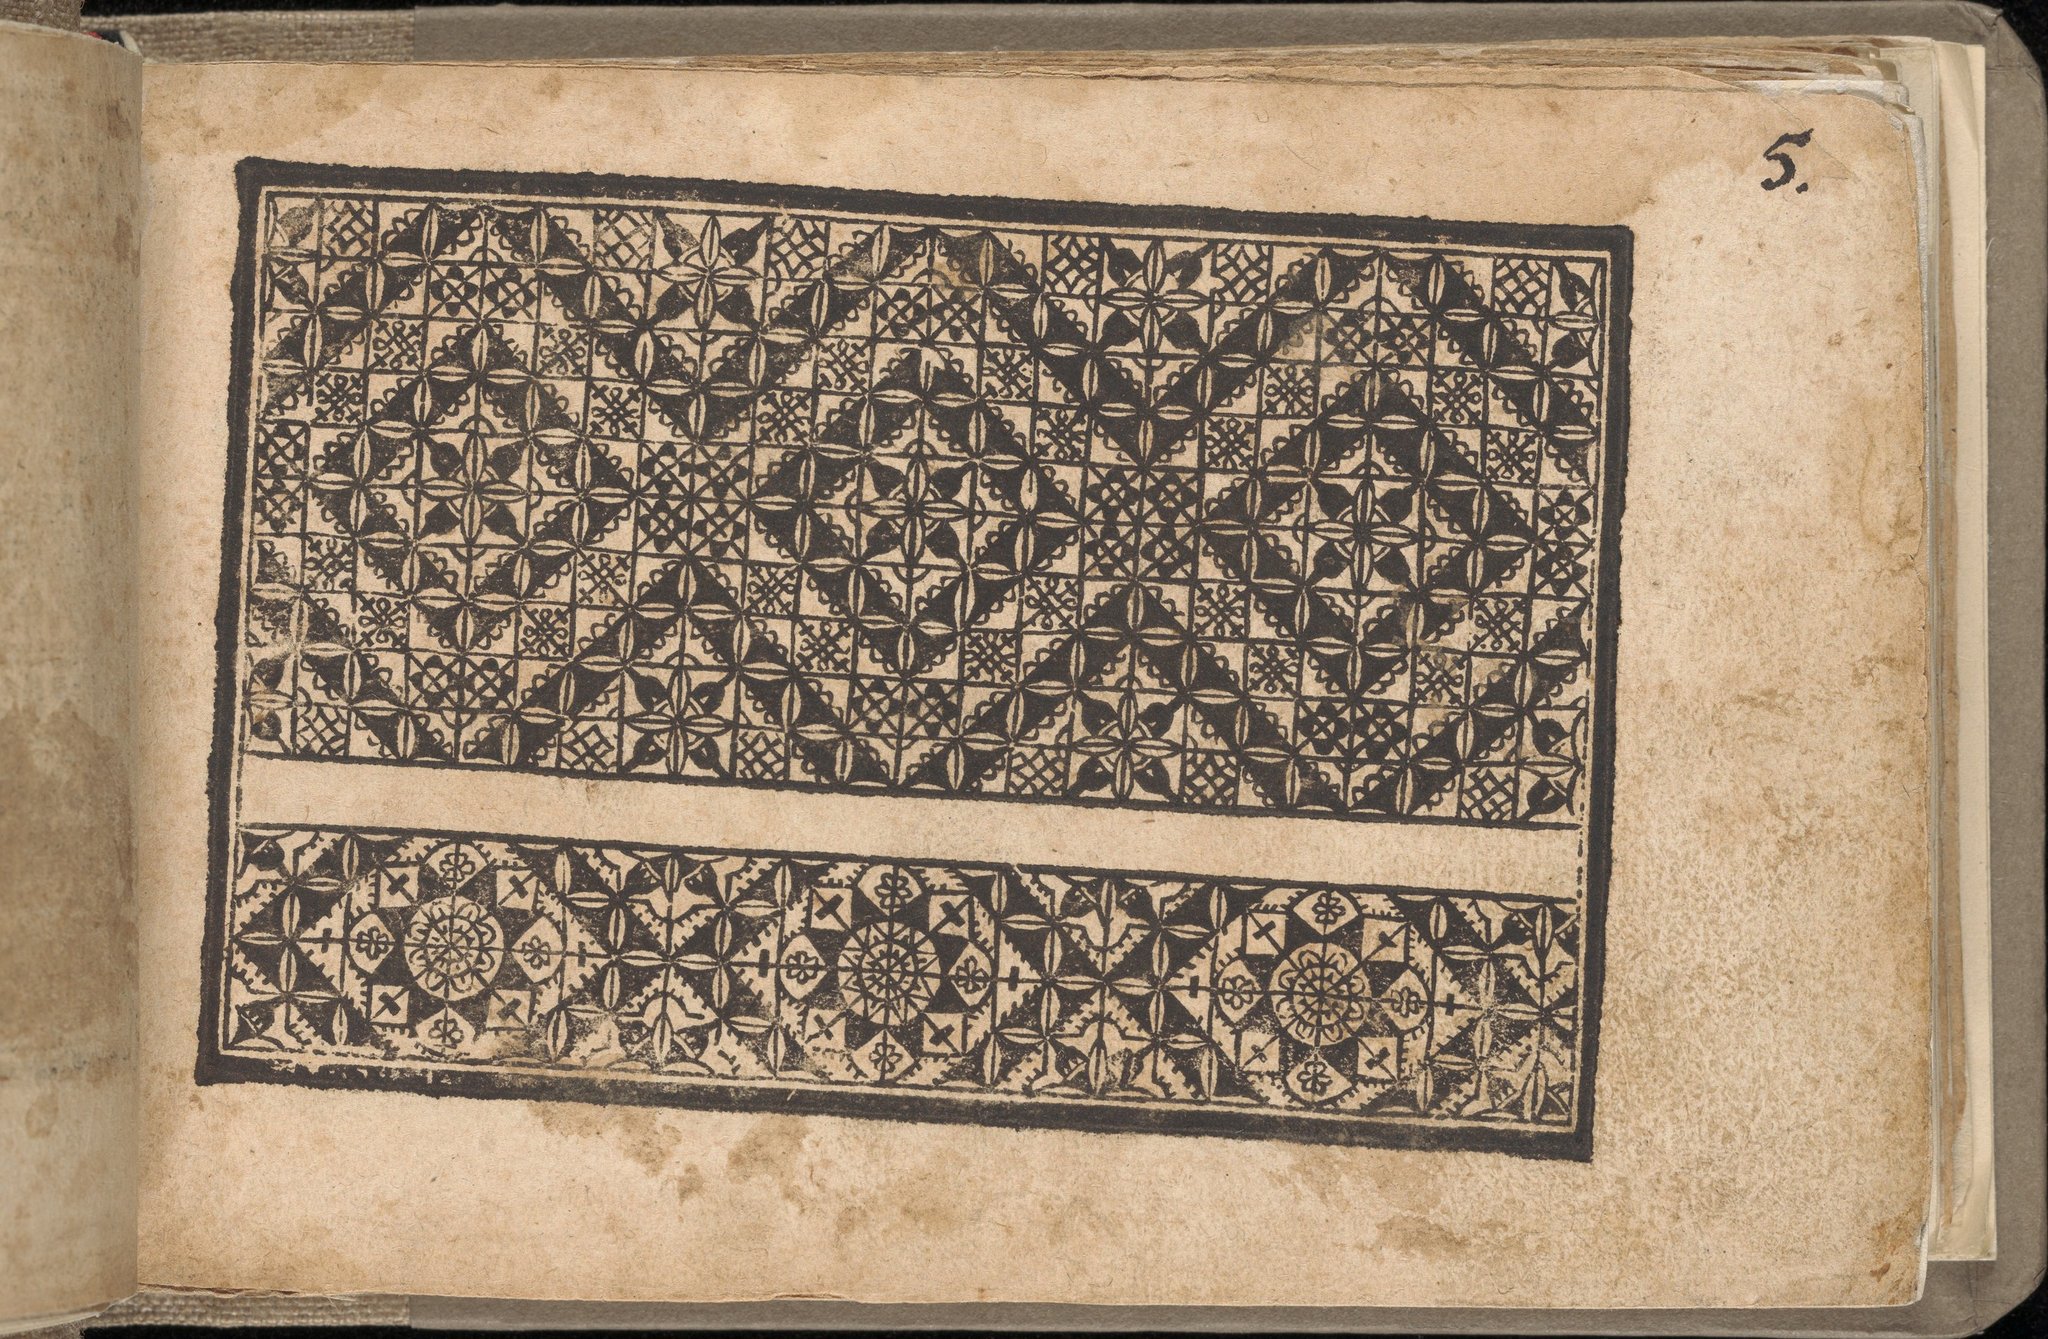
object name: book print ornament architecture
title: Schön newes Modelbuch (Page 5r)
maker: sigismundus latomus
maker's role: publisher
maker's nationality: german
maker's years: 1599-1632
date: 1608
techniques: woodcut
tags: ornament